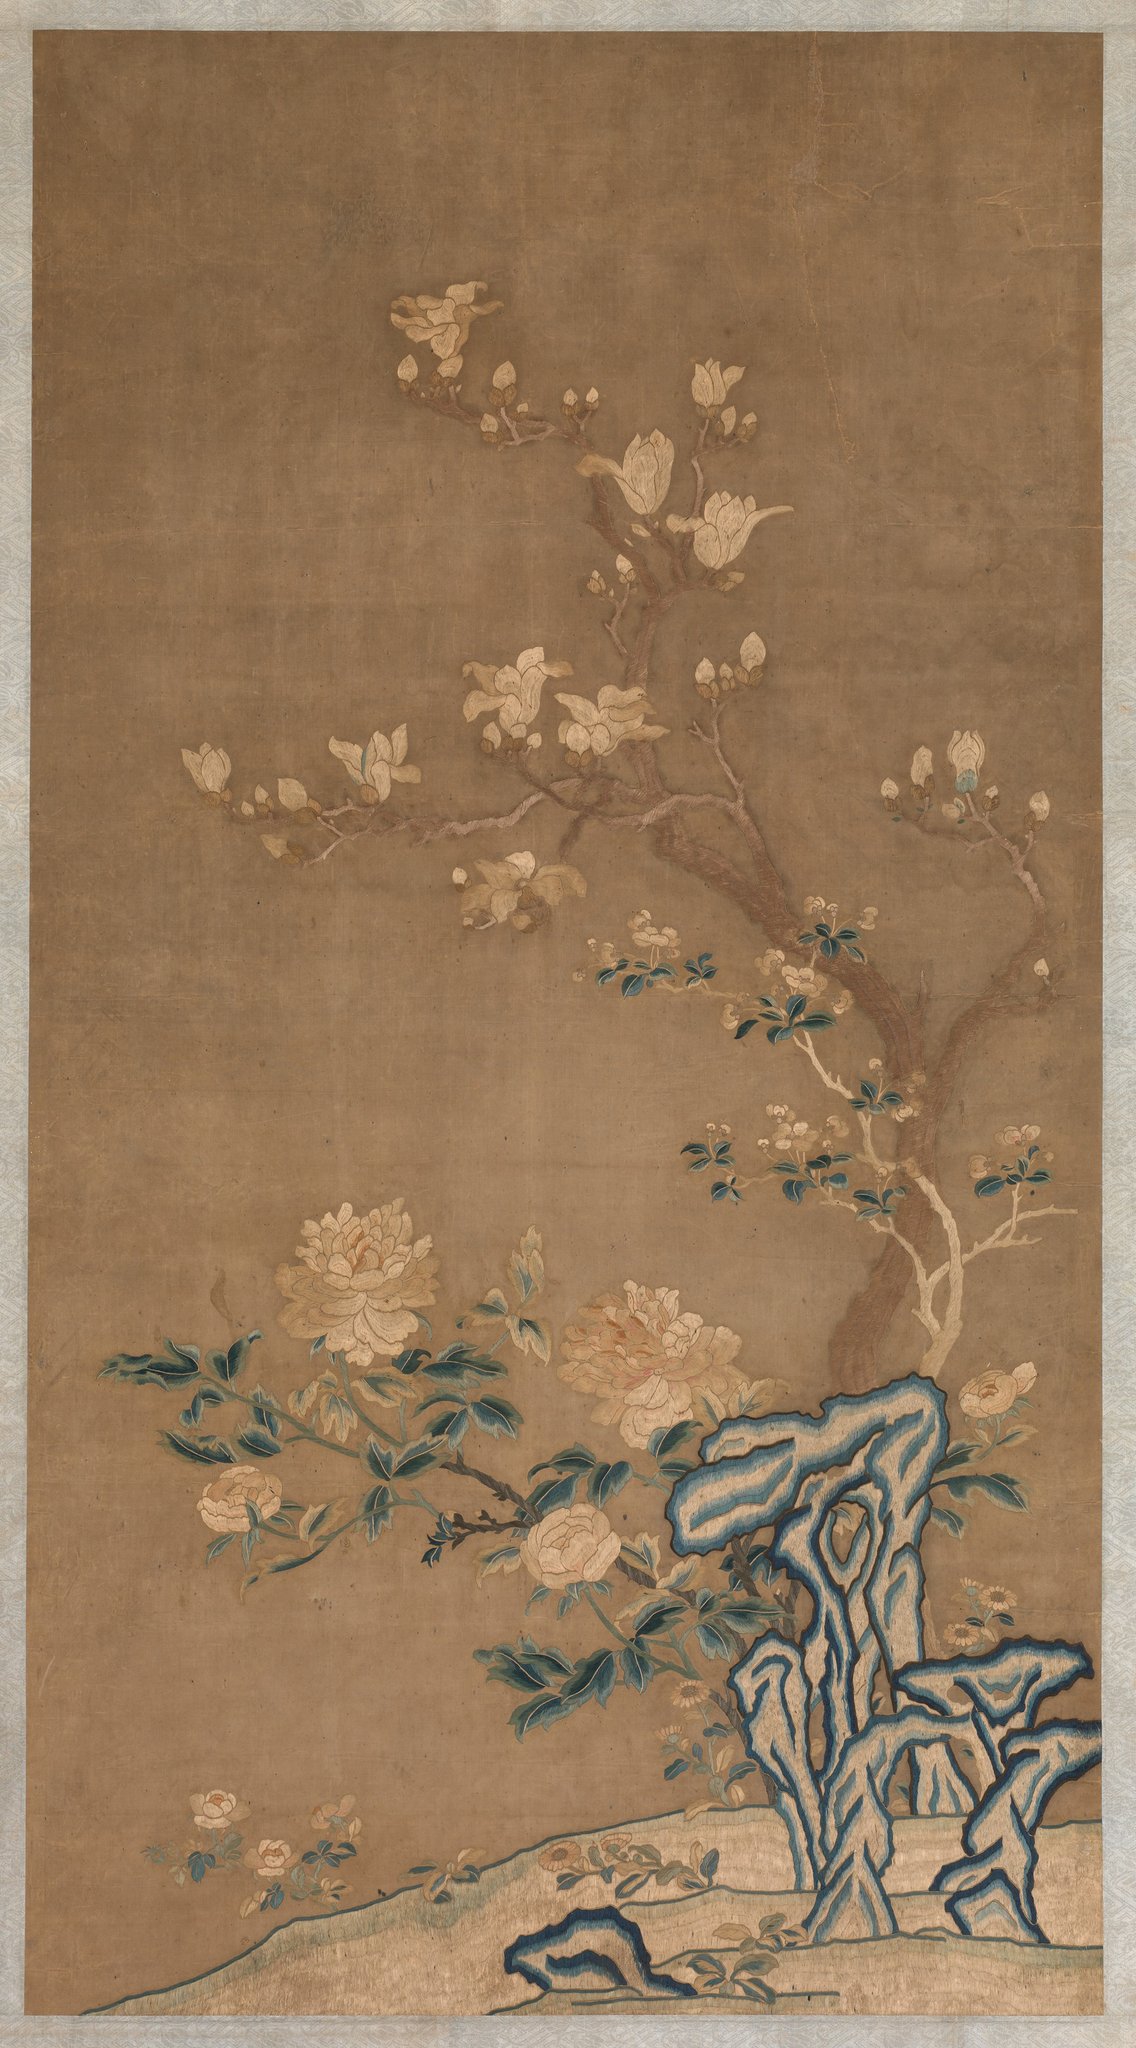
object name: vertical panel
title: Magnolia, crabapple, and tree peony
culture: chinese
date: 1667-1733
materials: silk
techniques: embroidery, weave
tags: flowers,peonies